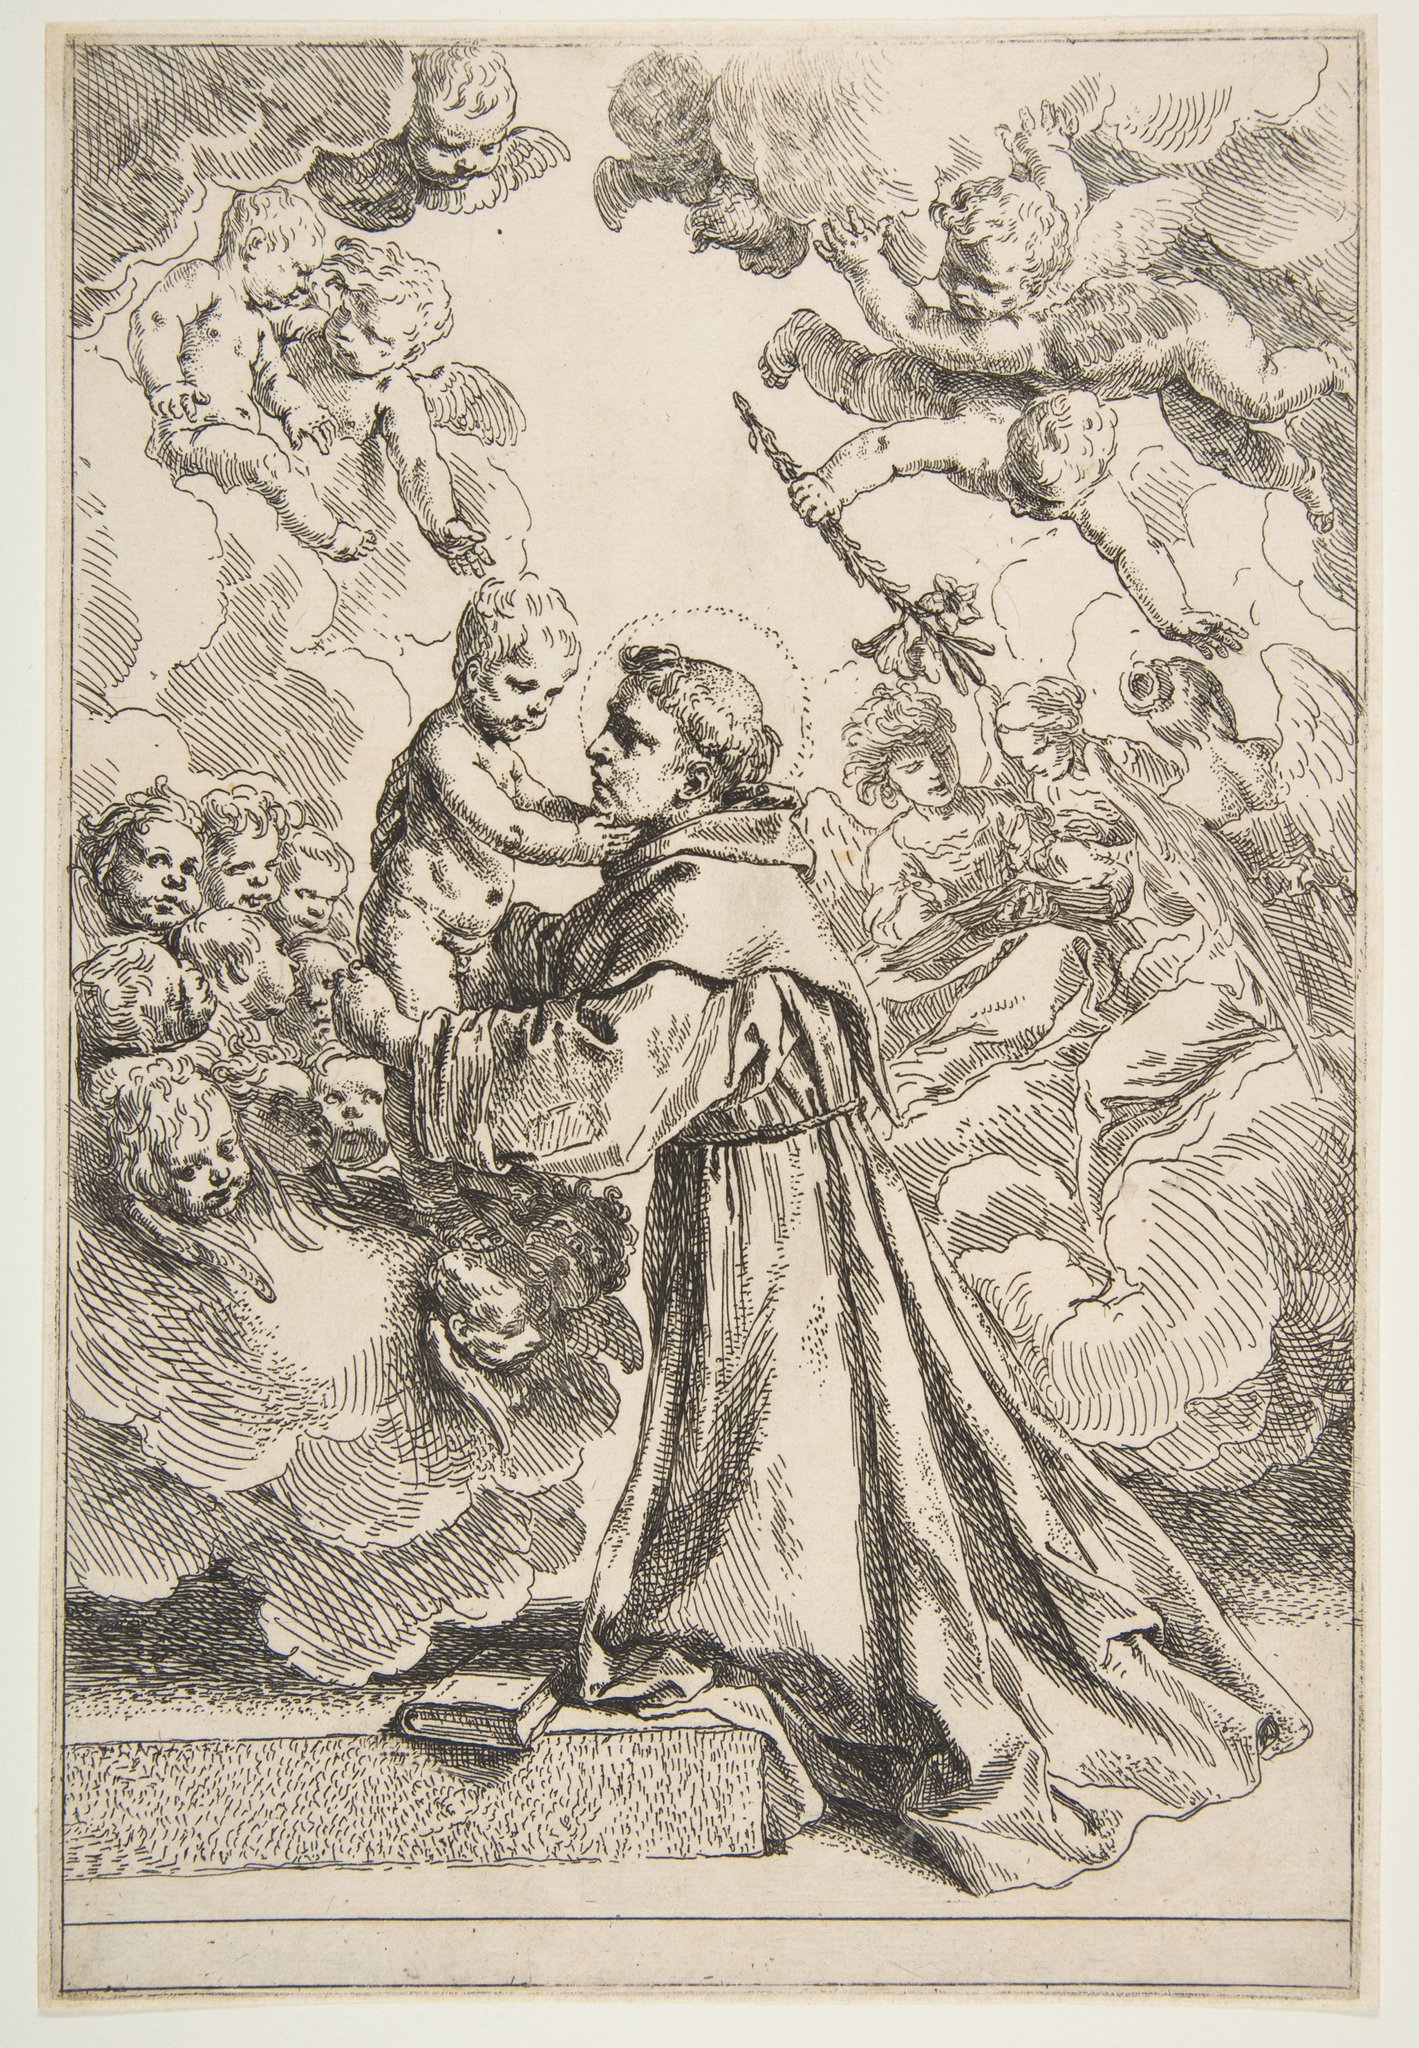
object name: print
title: Saint Anthony of Padua adoring the Christ Child in Glory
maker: simone cantarini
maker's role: artist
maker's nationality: italian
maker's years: 1612-1648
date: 1640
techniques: etching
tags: putti,angels,christ,saint anthony